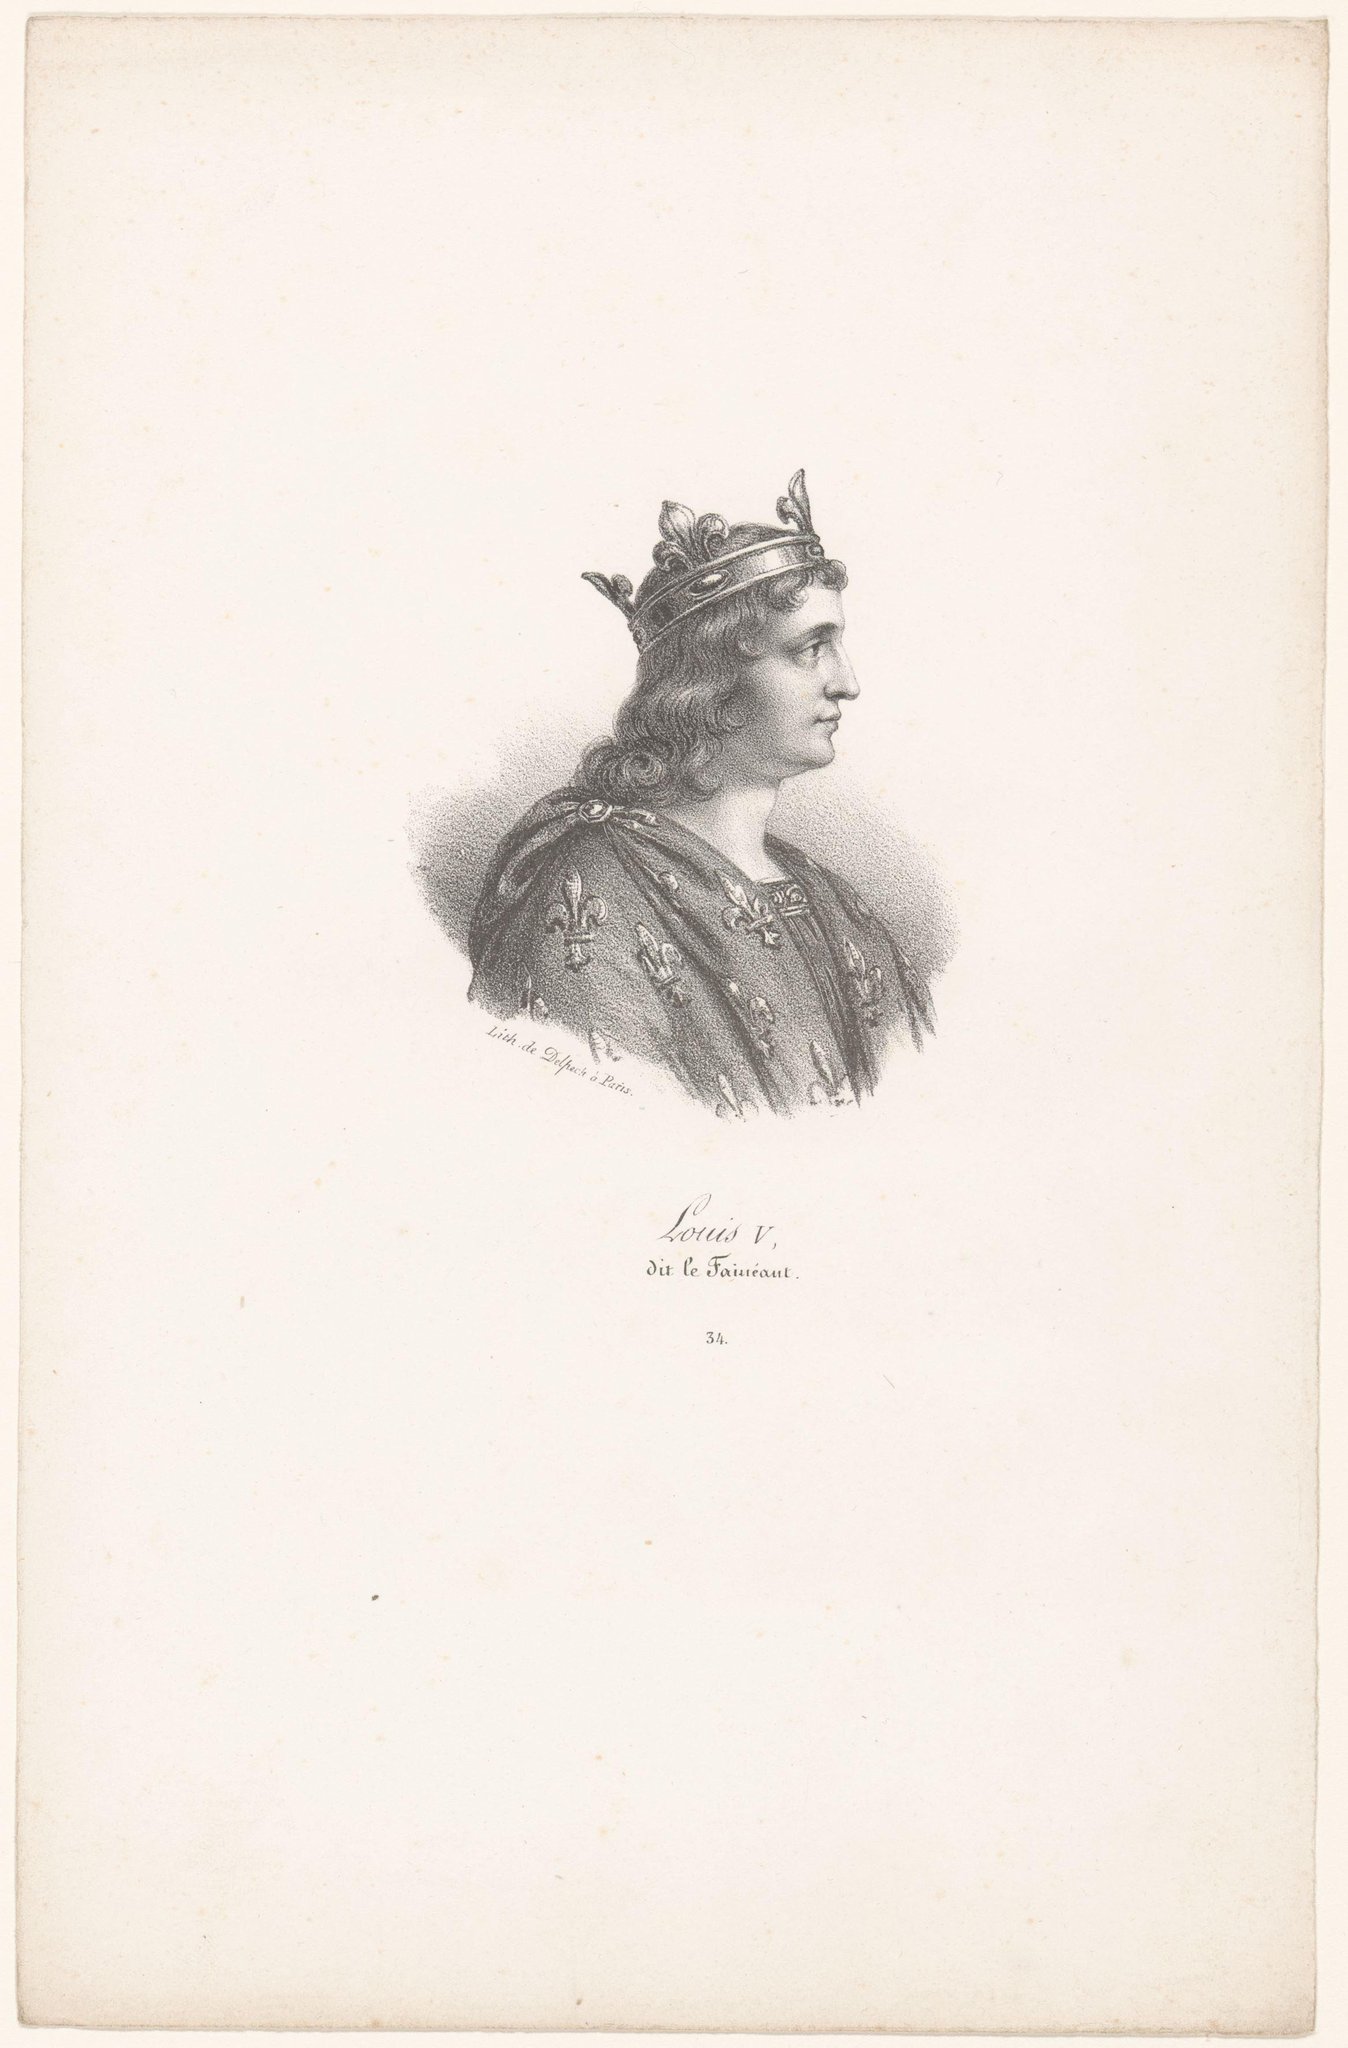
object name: print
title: Louis V, dit le Fainéant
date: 1818-1842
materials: paper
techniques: lithograph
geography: paris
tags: historical persons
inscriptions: collector's mark: Lugt 2228a